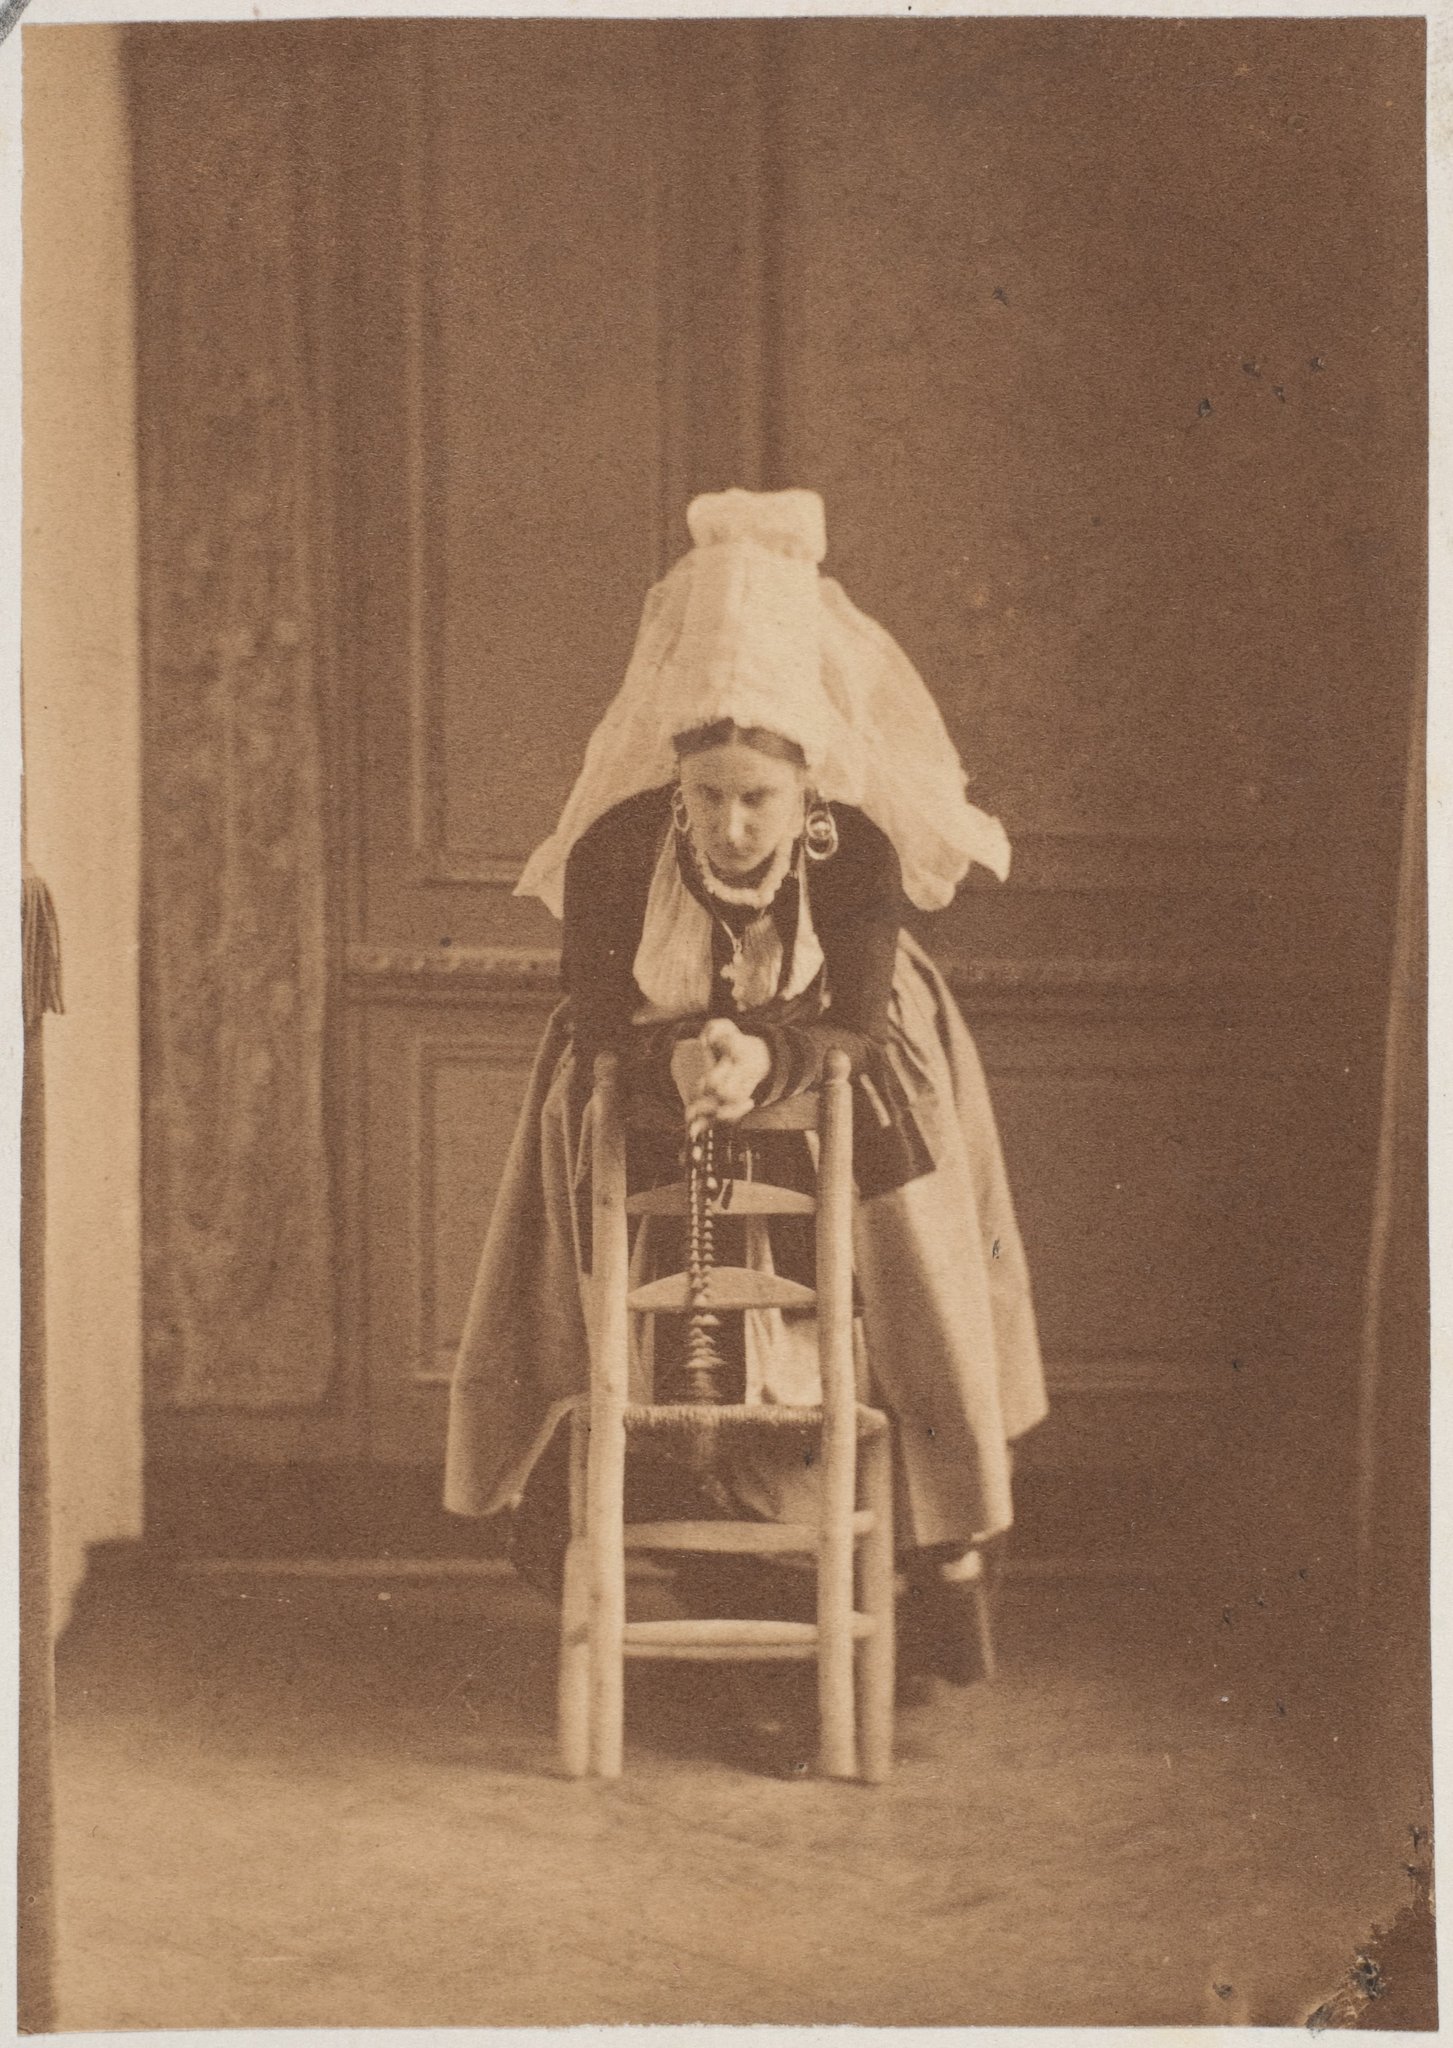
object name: photograph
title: Stella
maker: pierre-louis pierson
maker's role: artist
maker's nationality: french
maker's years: 1822-1913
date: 1860-1869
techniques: albumen silver print, glass negative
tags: portraits,women